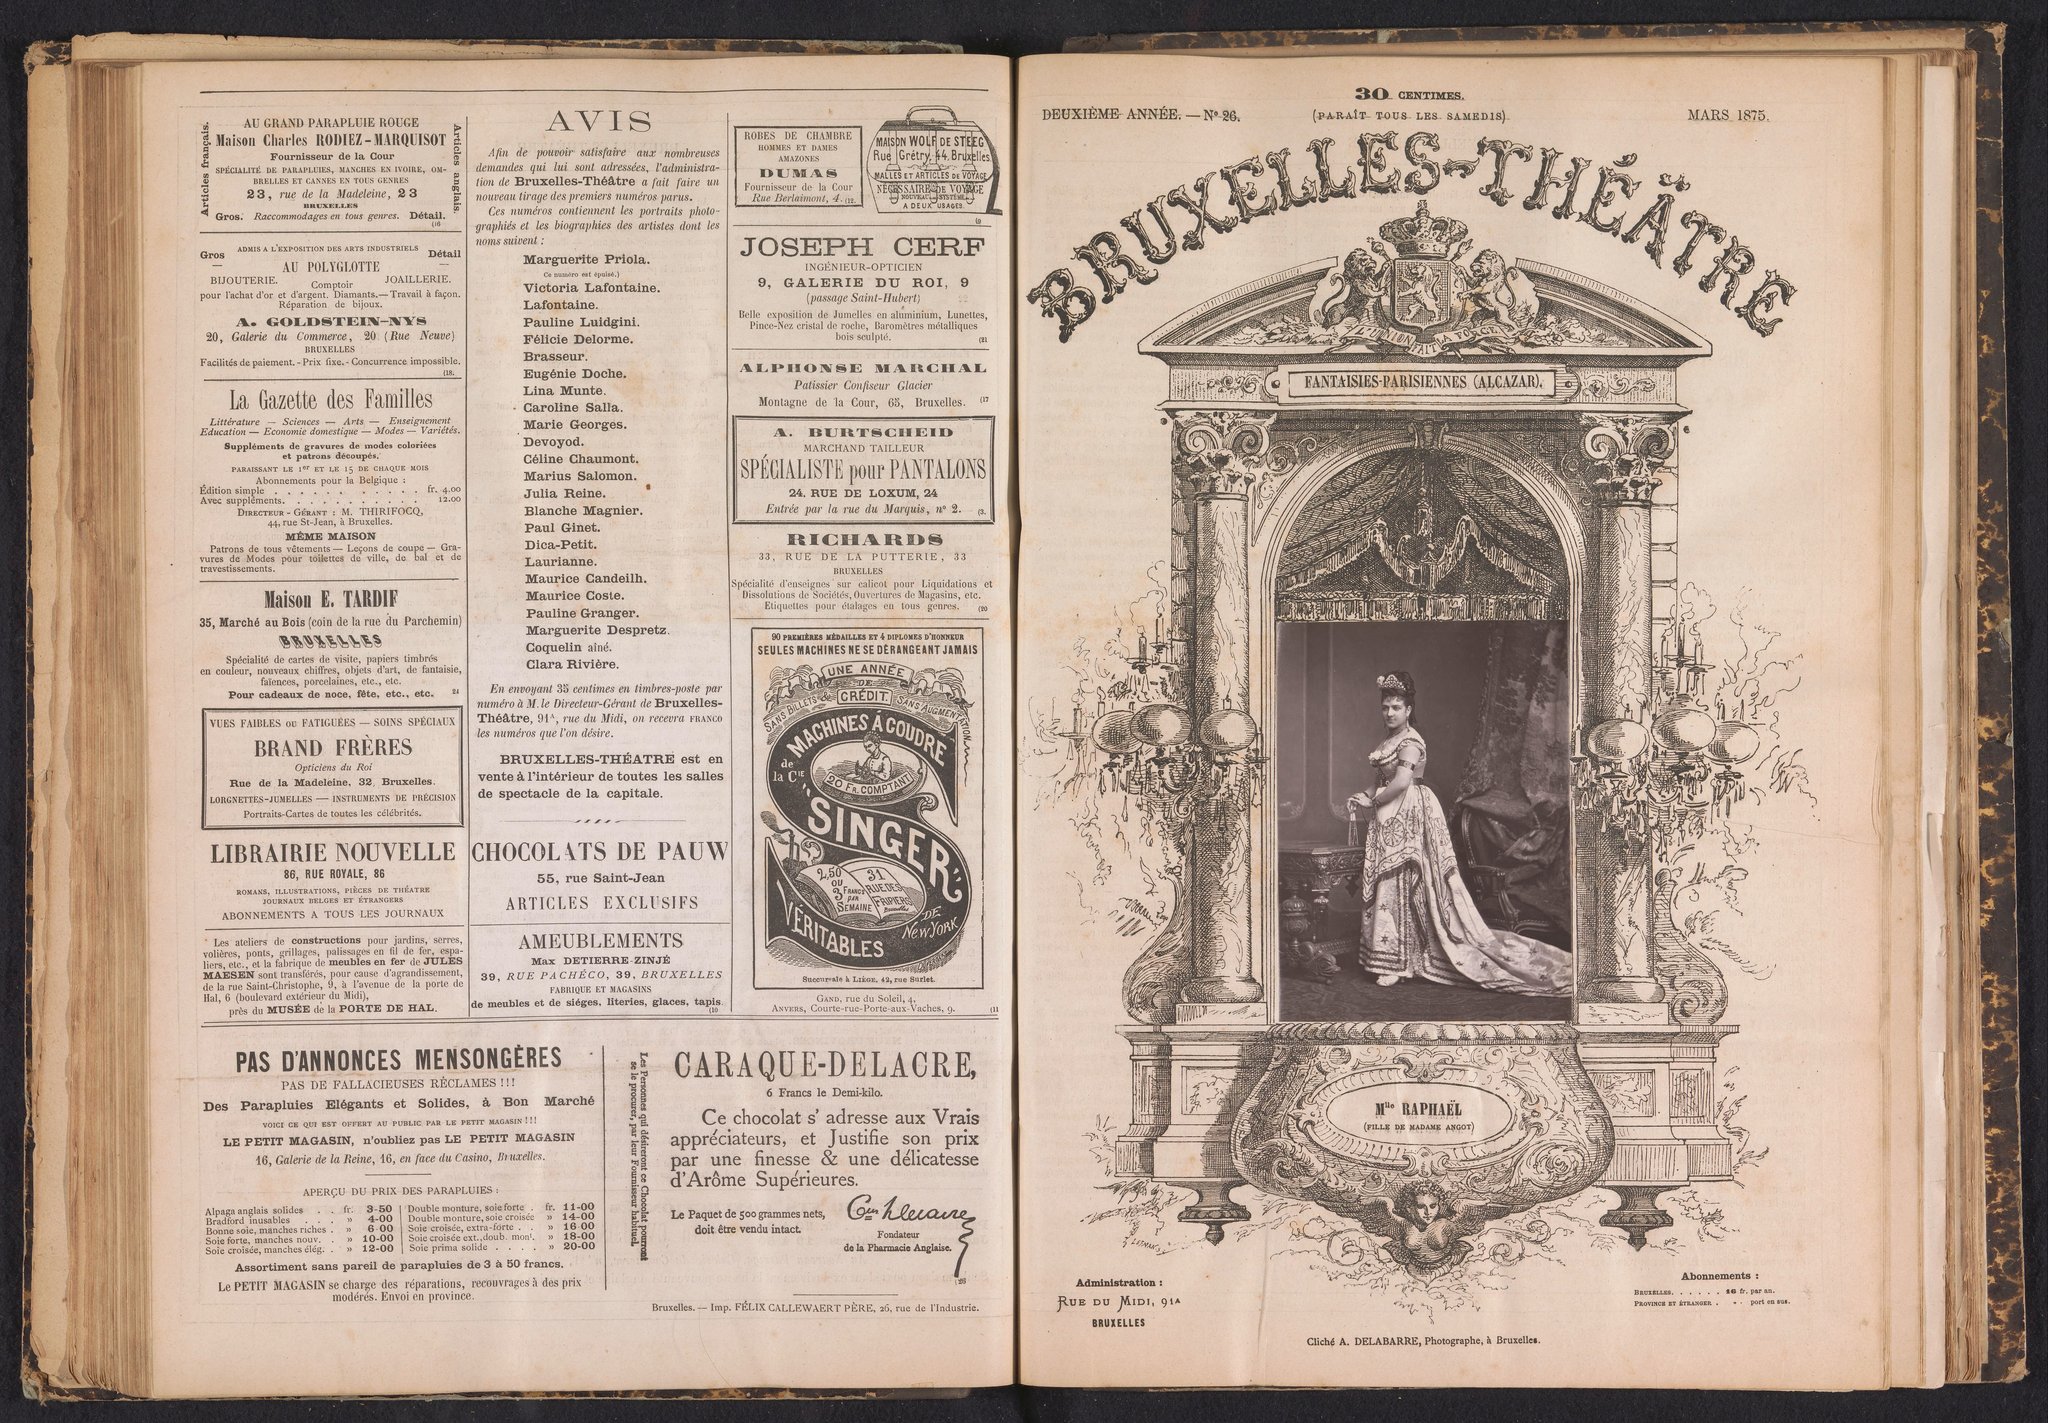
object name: page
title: Portret van mademoiselle Raphaël in Fille de madame Angot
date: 1870-1875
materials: paper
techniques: woodburytype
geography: brussels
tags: portrait of actor, actress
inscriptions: number: ‘No 26.’